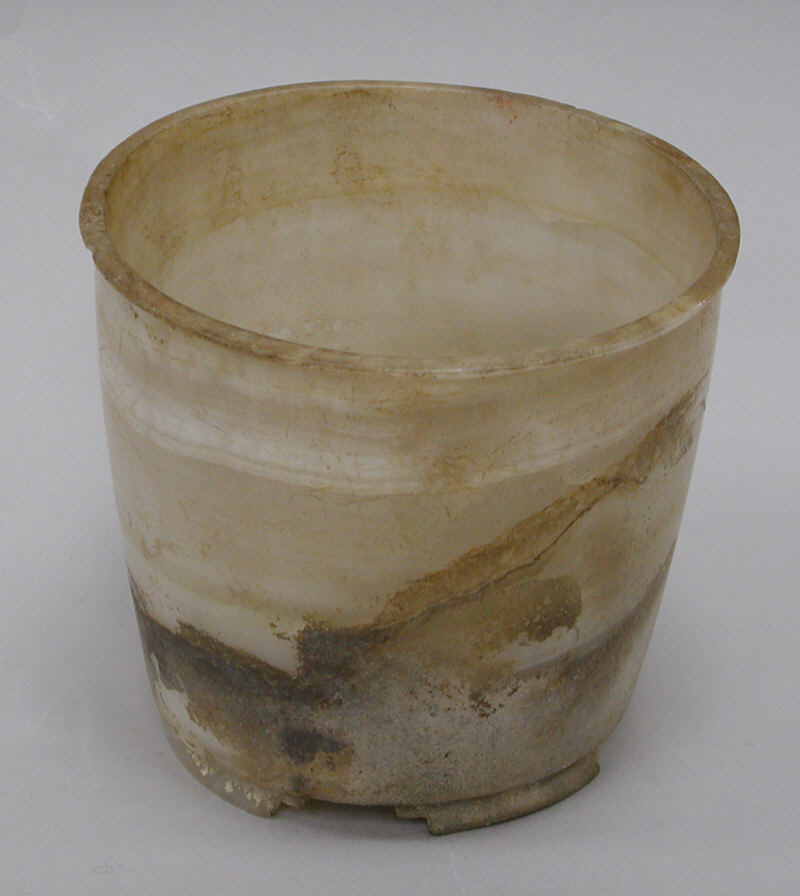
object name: vessel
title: Tripod Onyx Vessel (tecalli)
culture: mexican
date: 1501-1600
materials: marble, onyx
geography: mexico